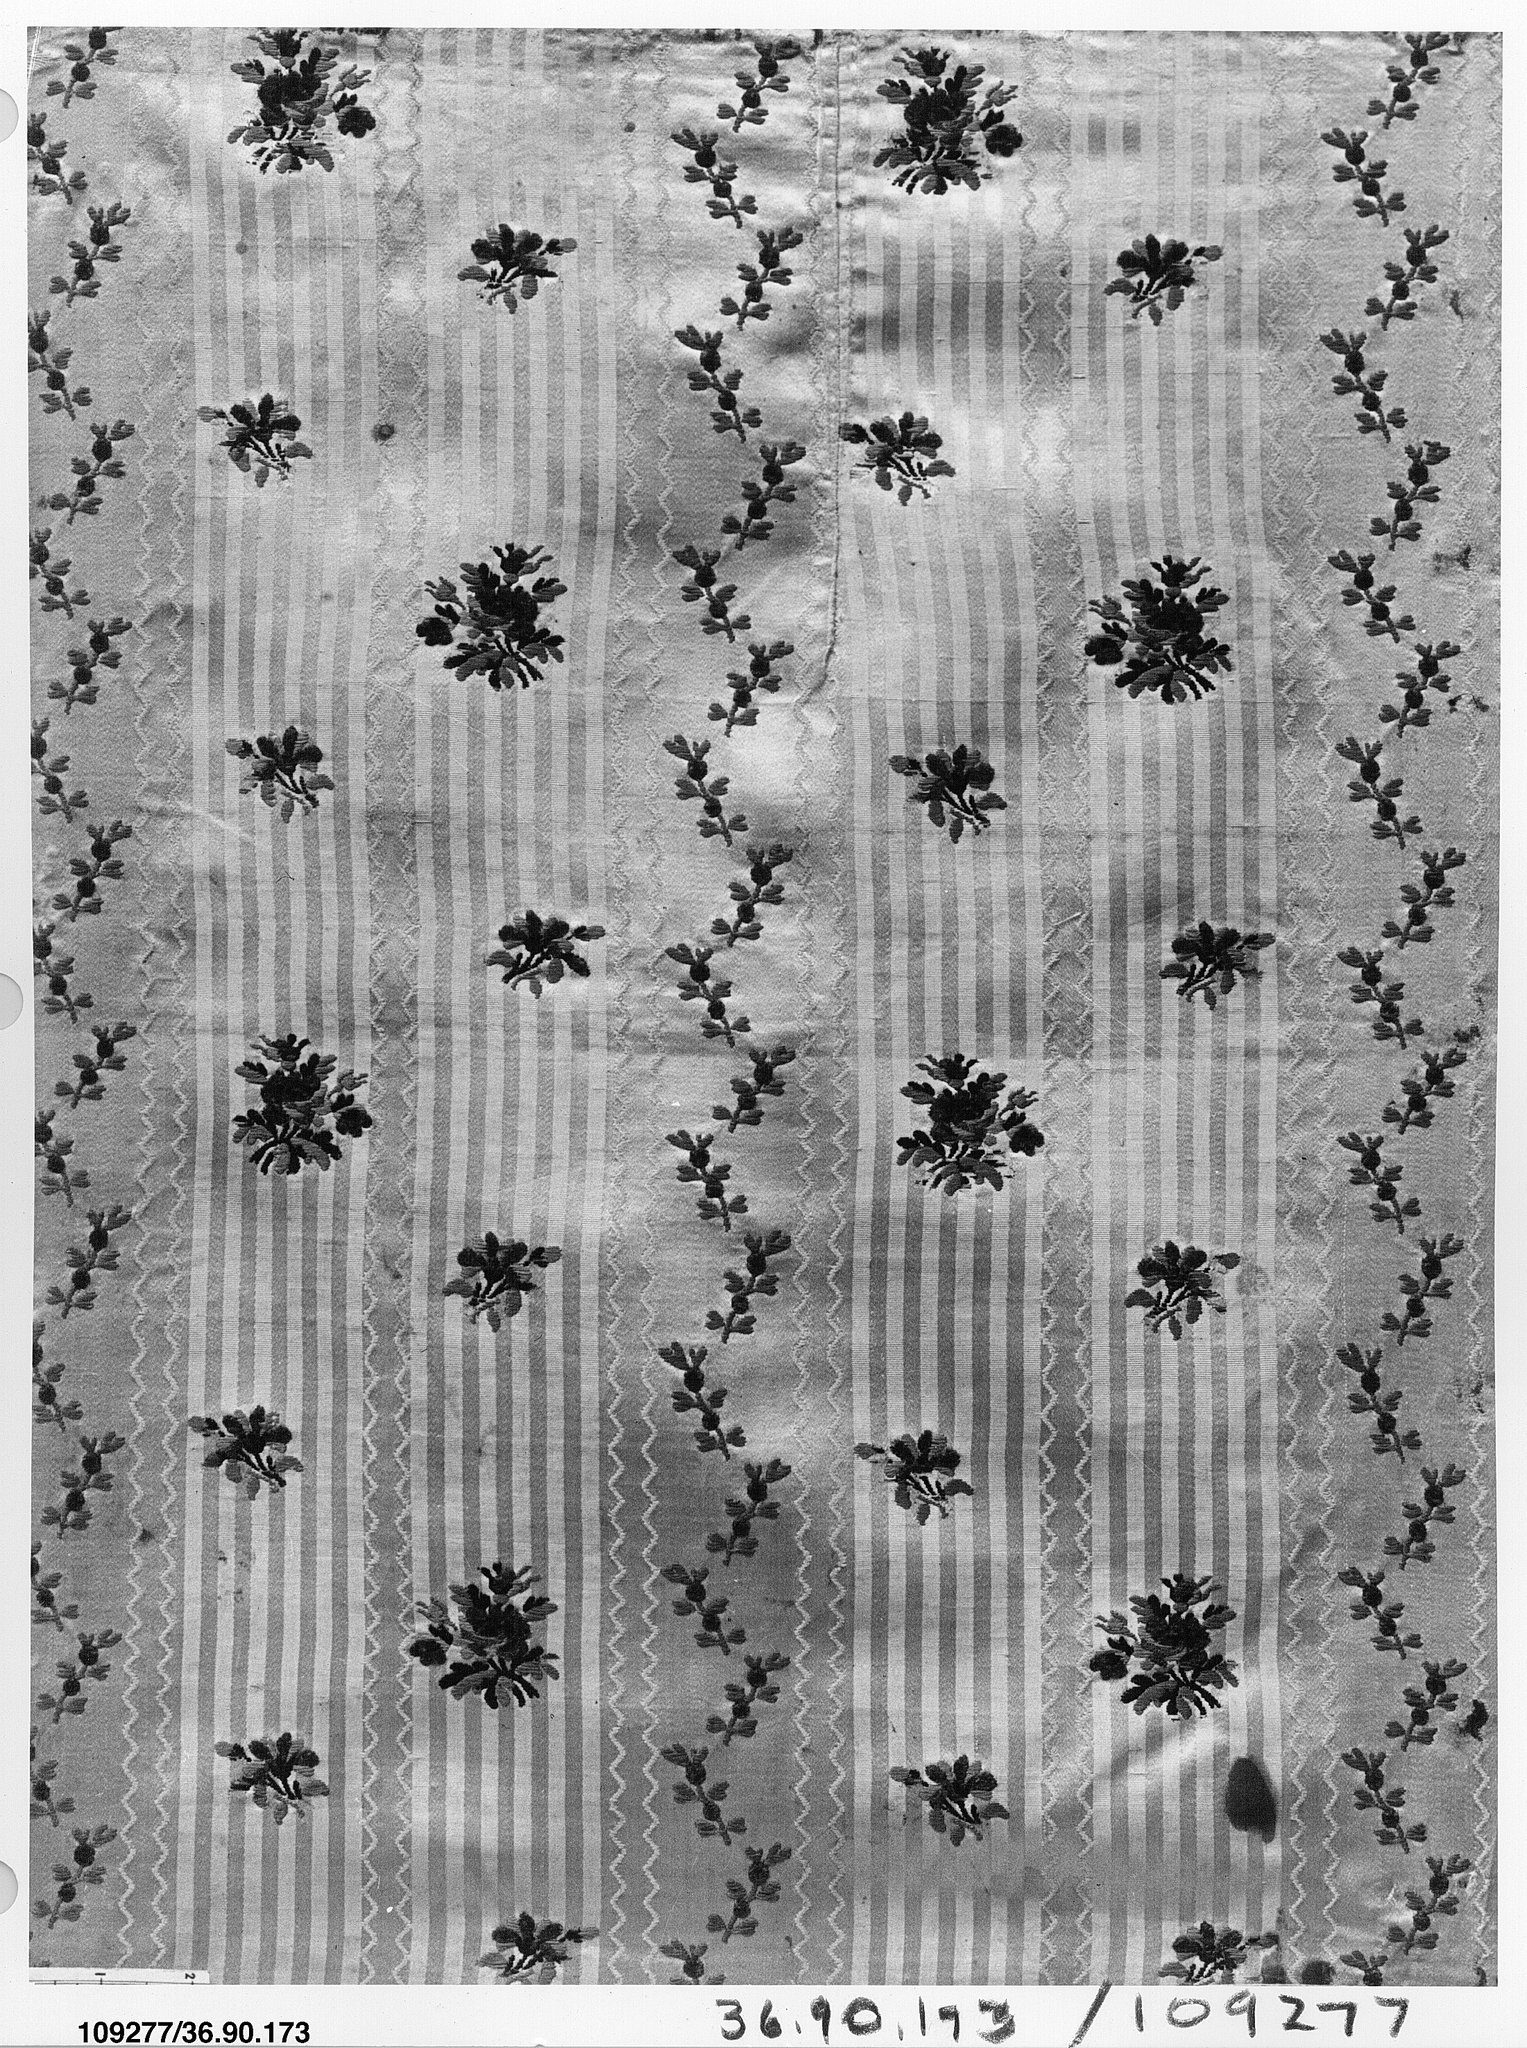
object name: piece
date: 1701-1800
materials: silk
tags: flowers